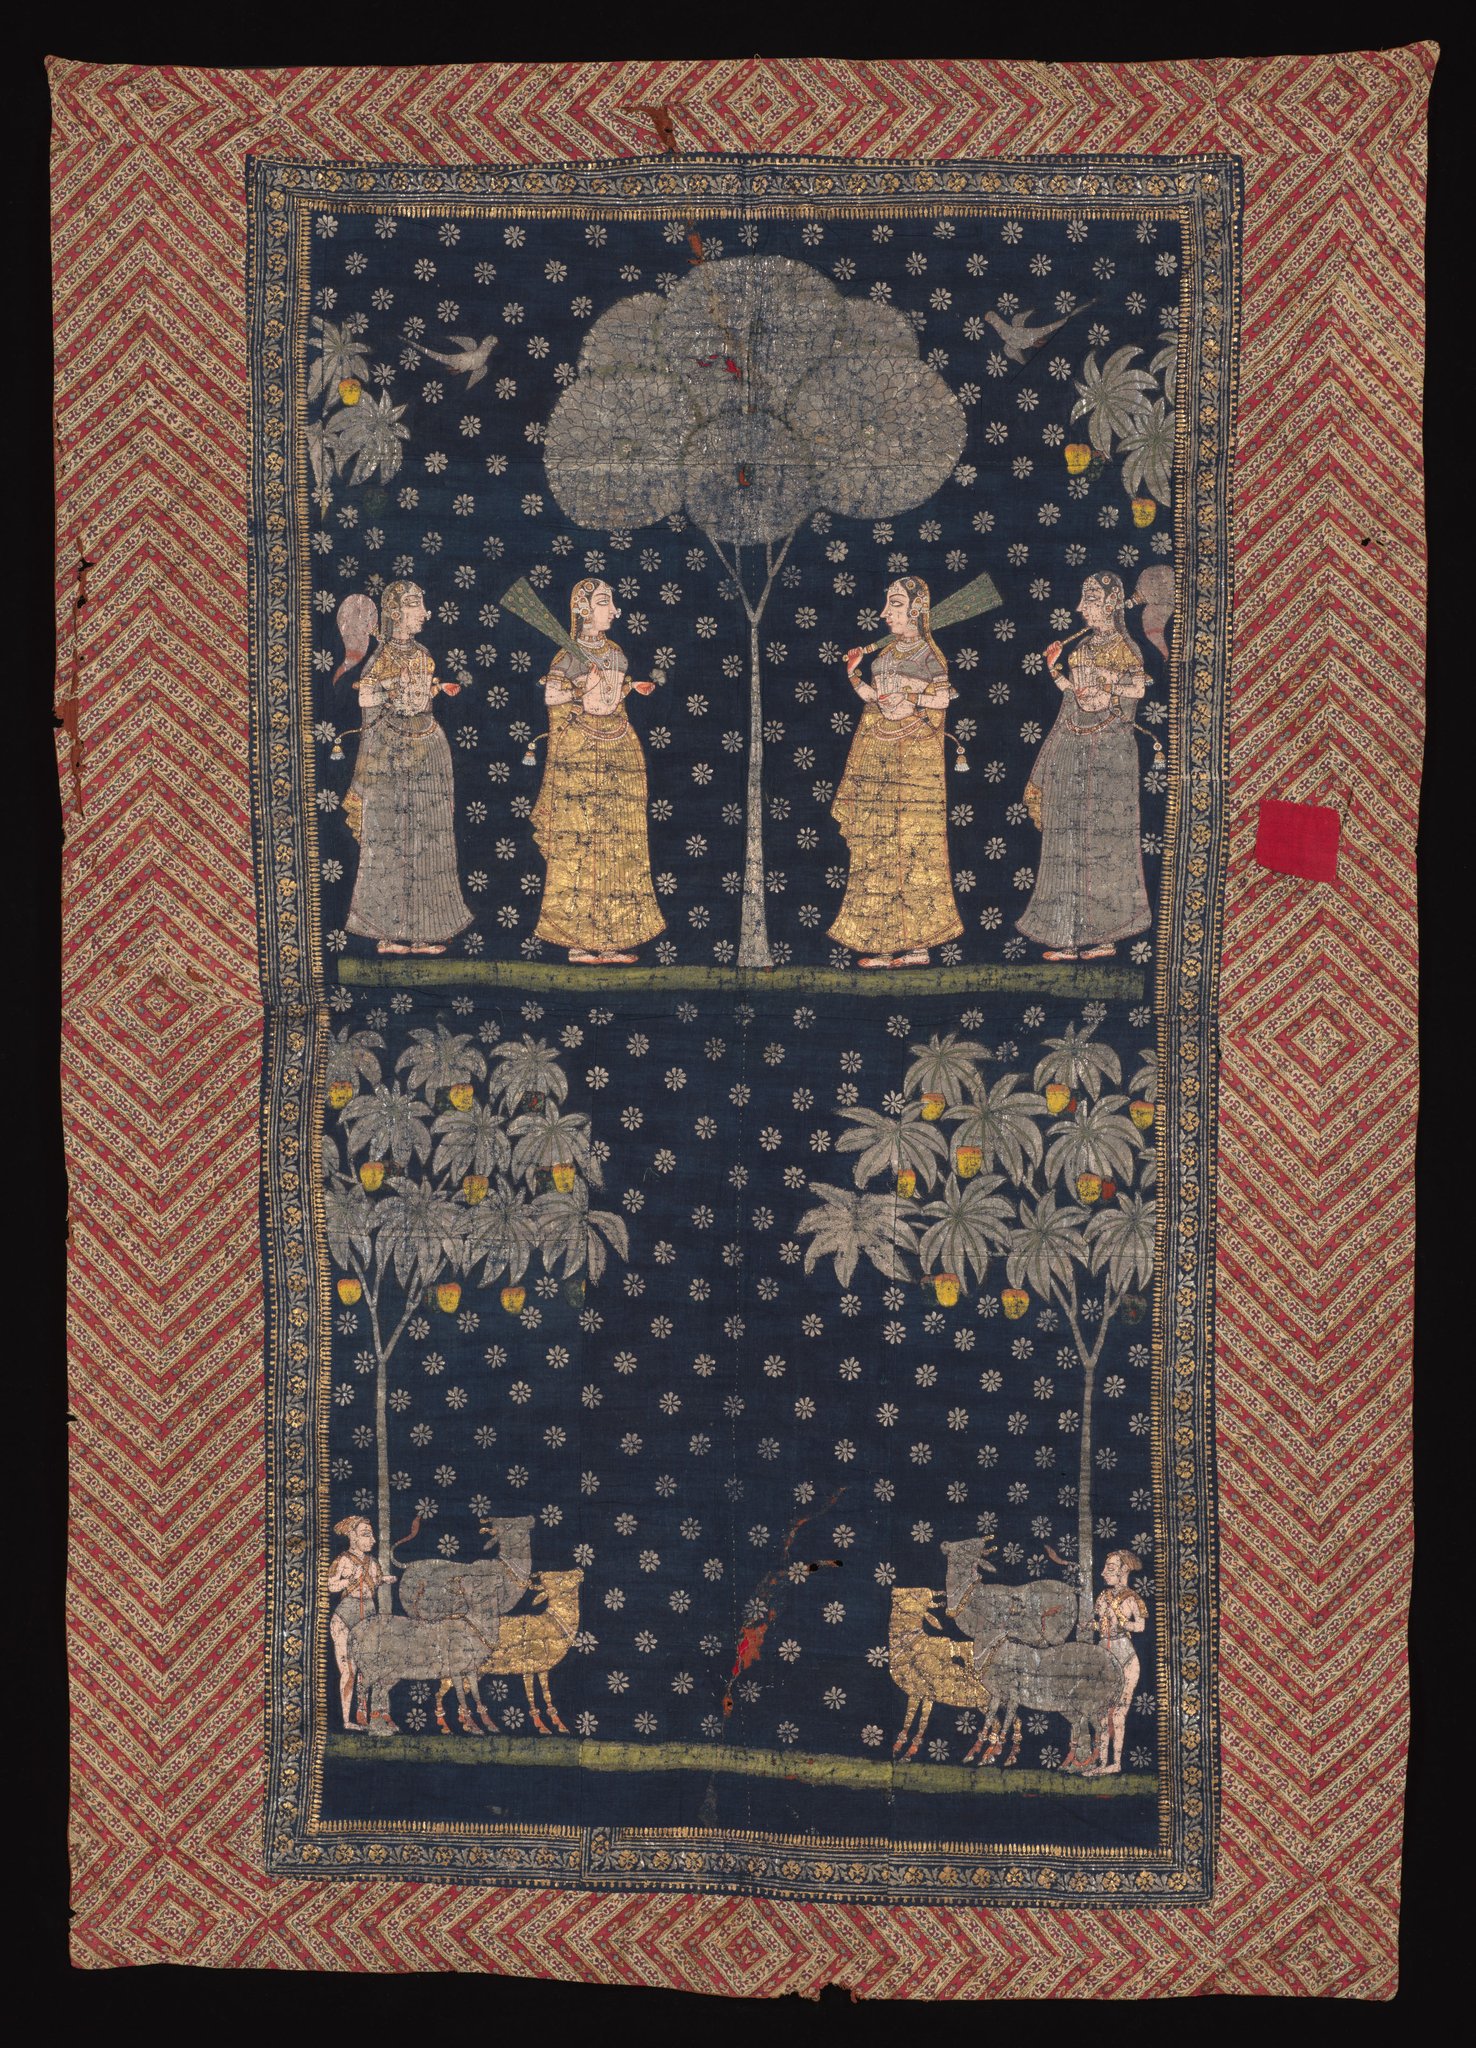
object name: picchavai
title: Temple cloth celebrating Krishna (pichhavai)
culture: indian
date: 1801-1900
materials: cotton, gold, pigment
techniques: painting